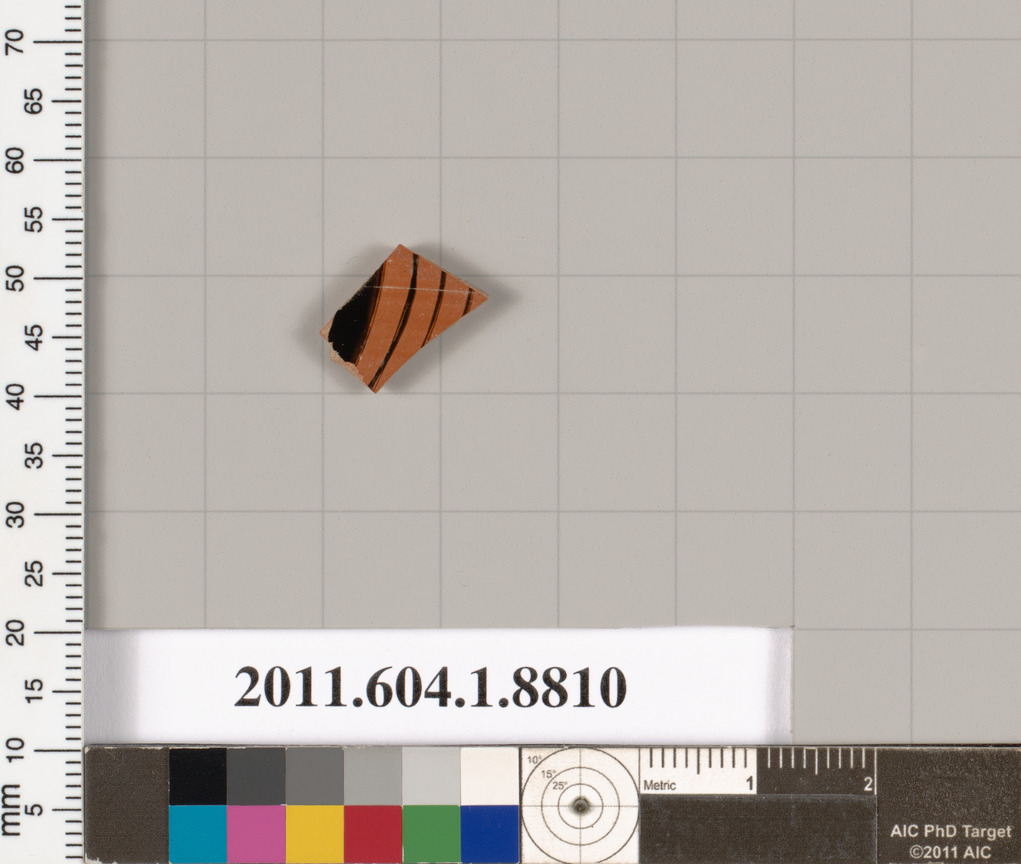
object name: kylix fragment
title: Terracotta fragment of a kylix (drinking cup)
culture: greek, attic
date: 490-470 BCE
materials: terracotta